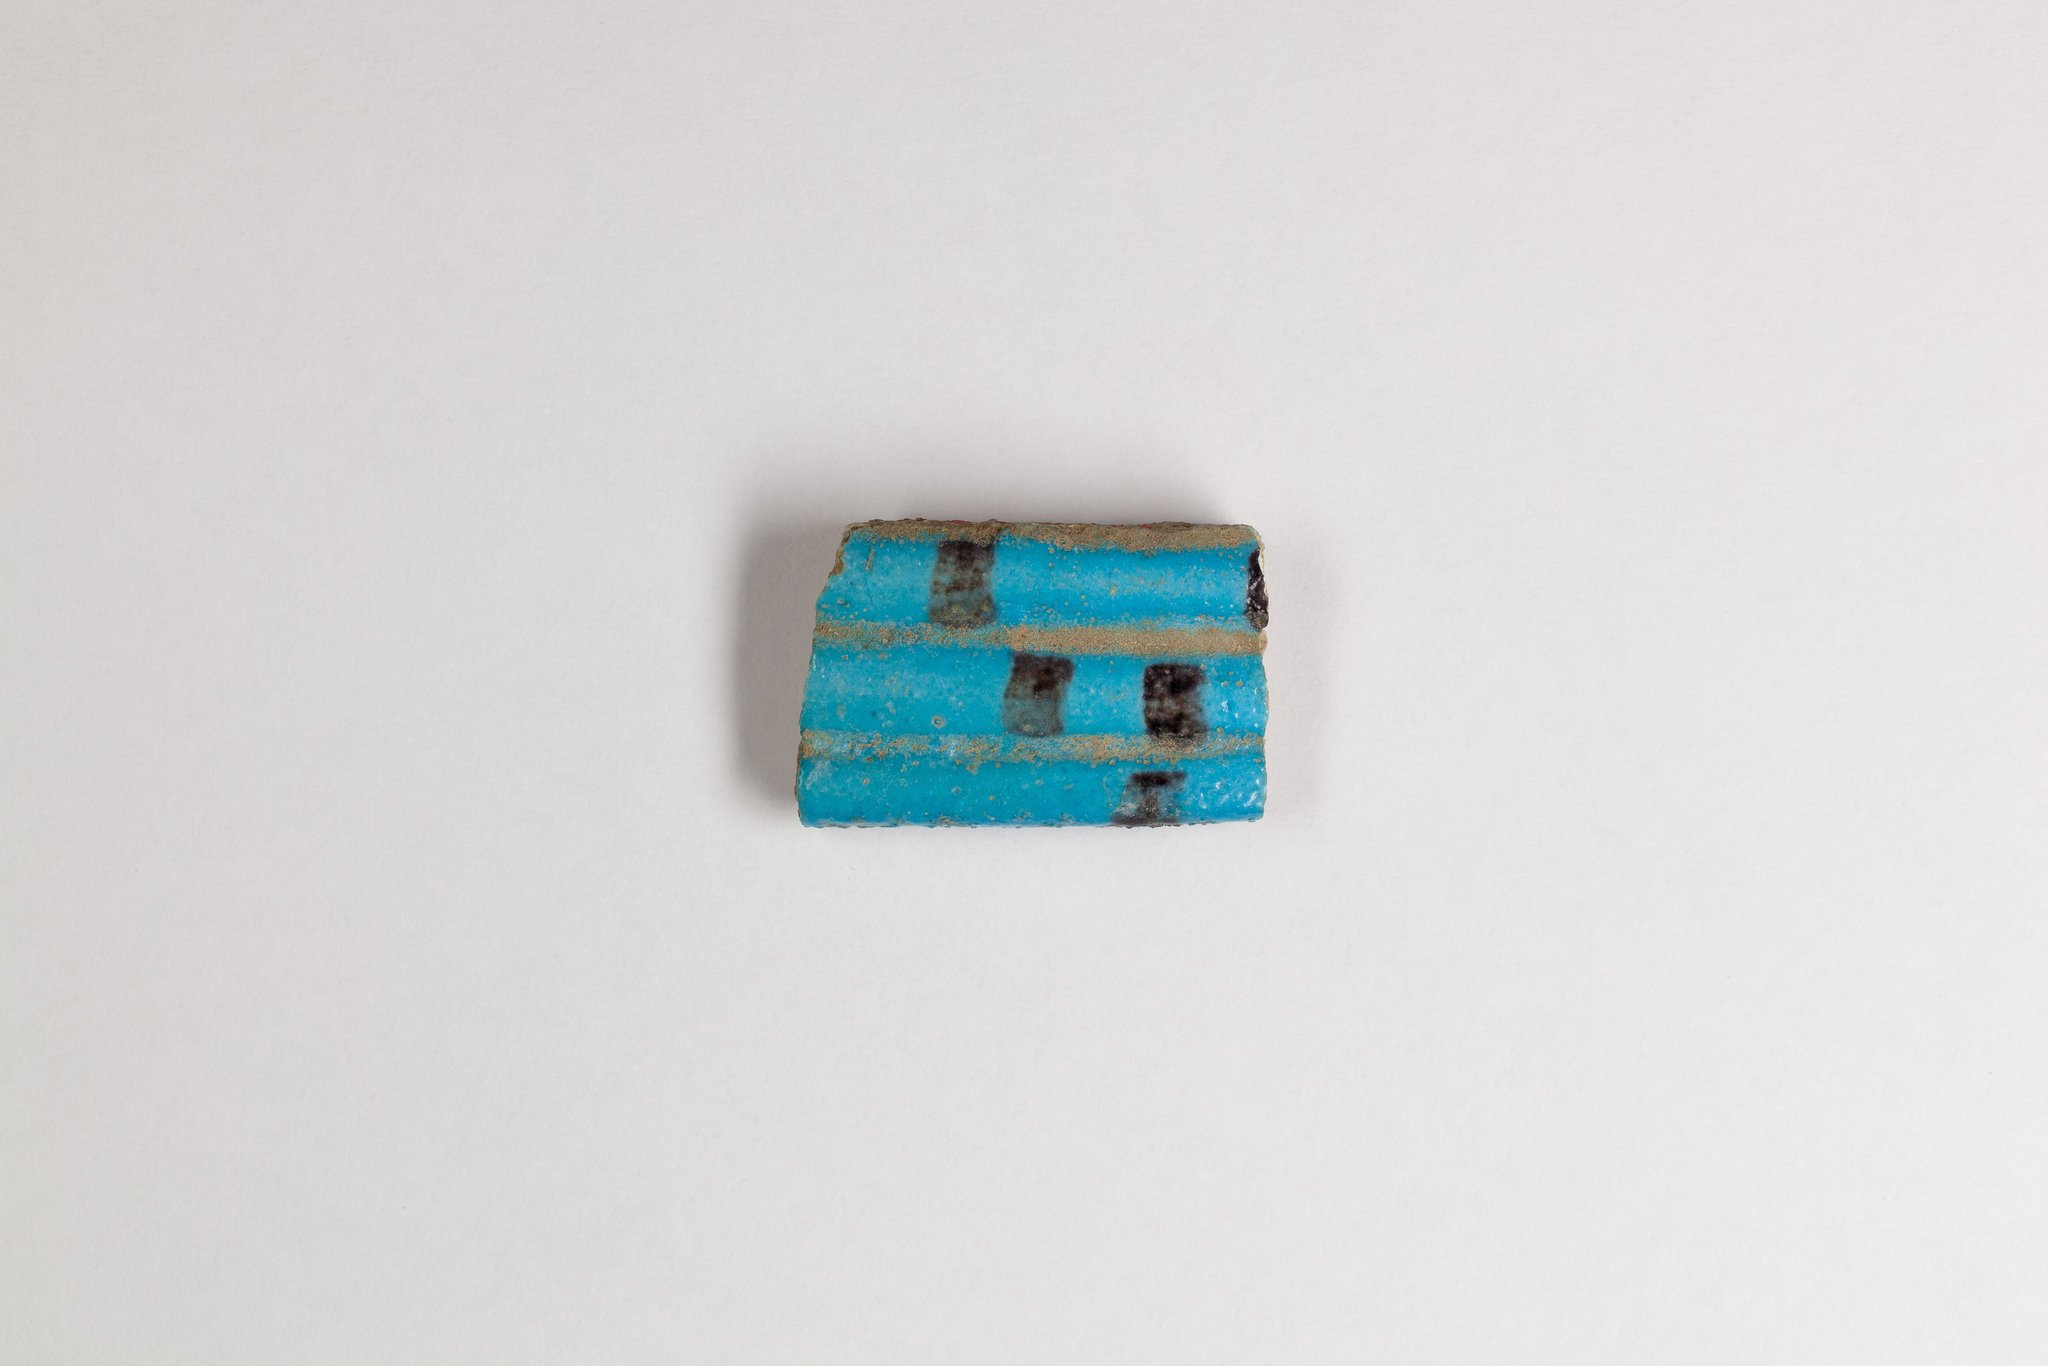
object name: vase fragment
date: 1981-1640 BCE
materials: faience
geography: egypt